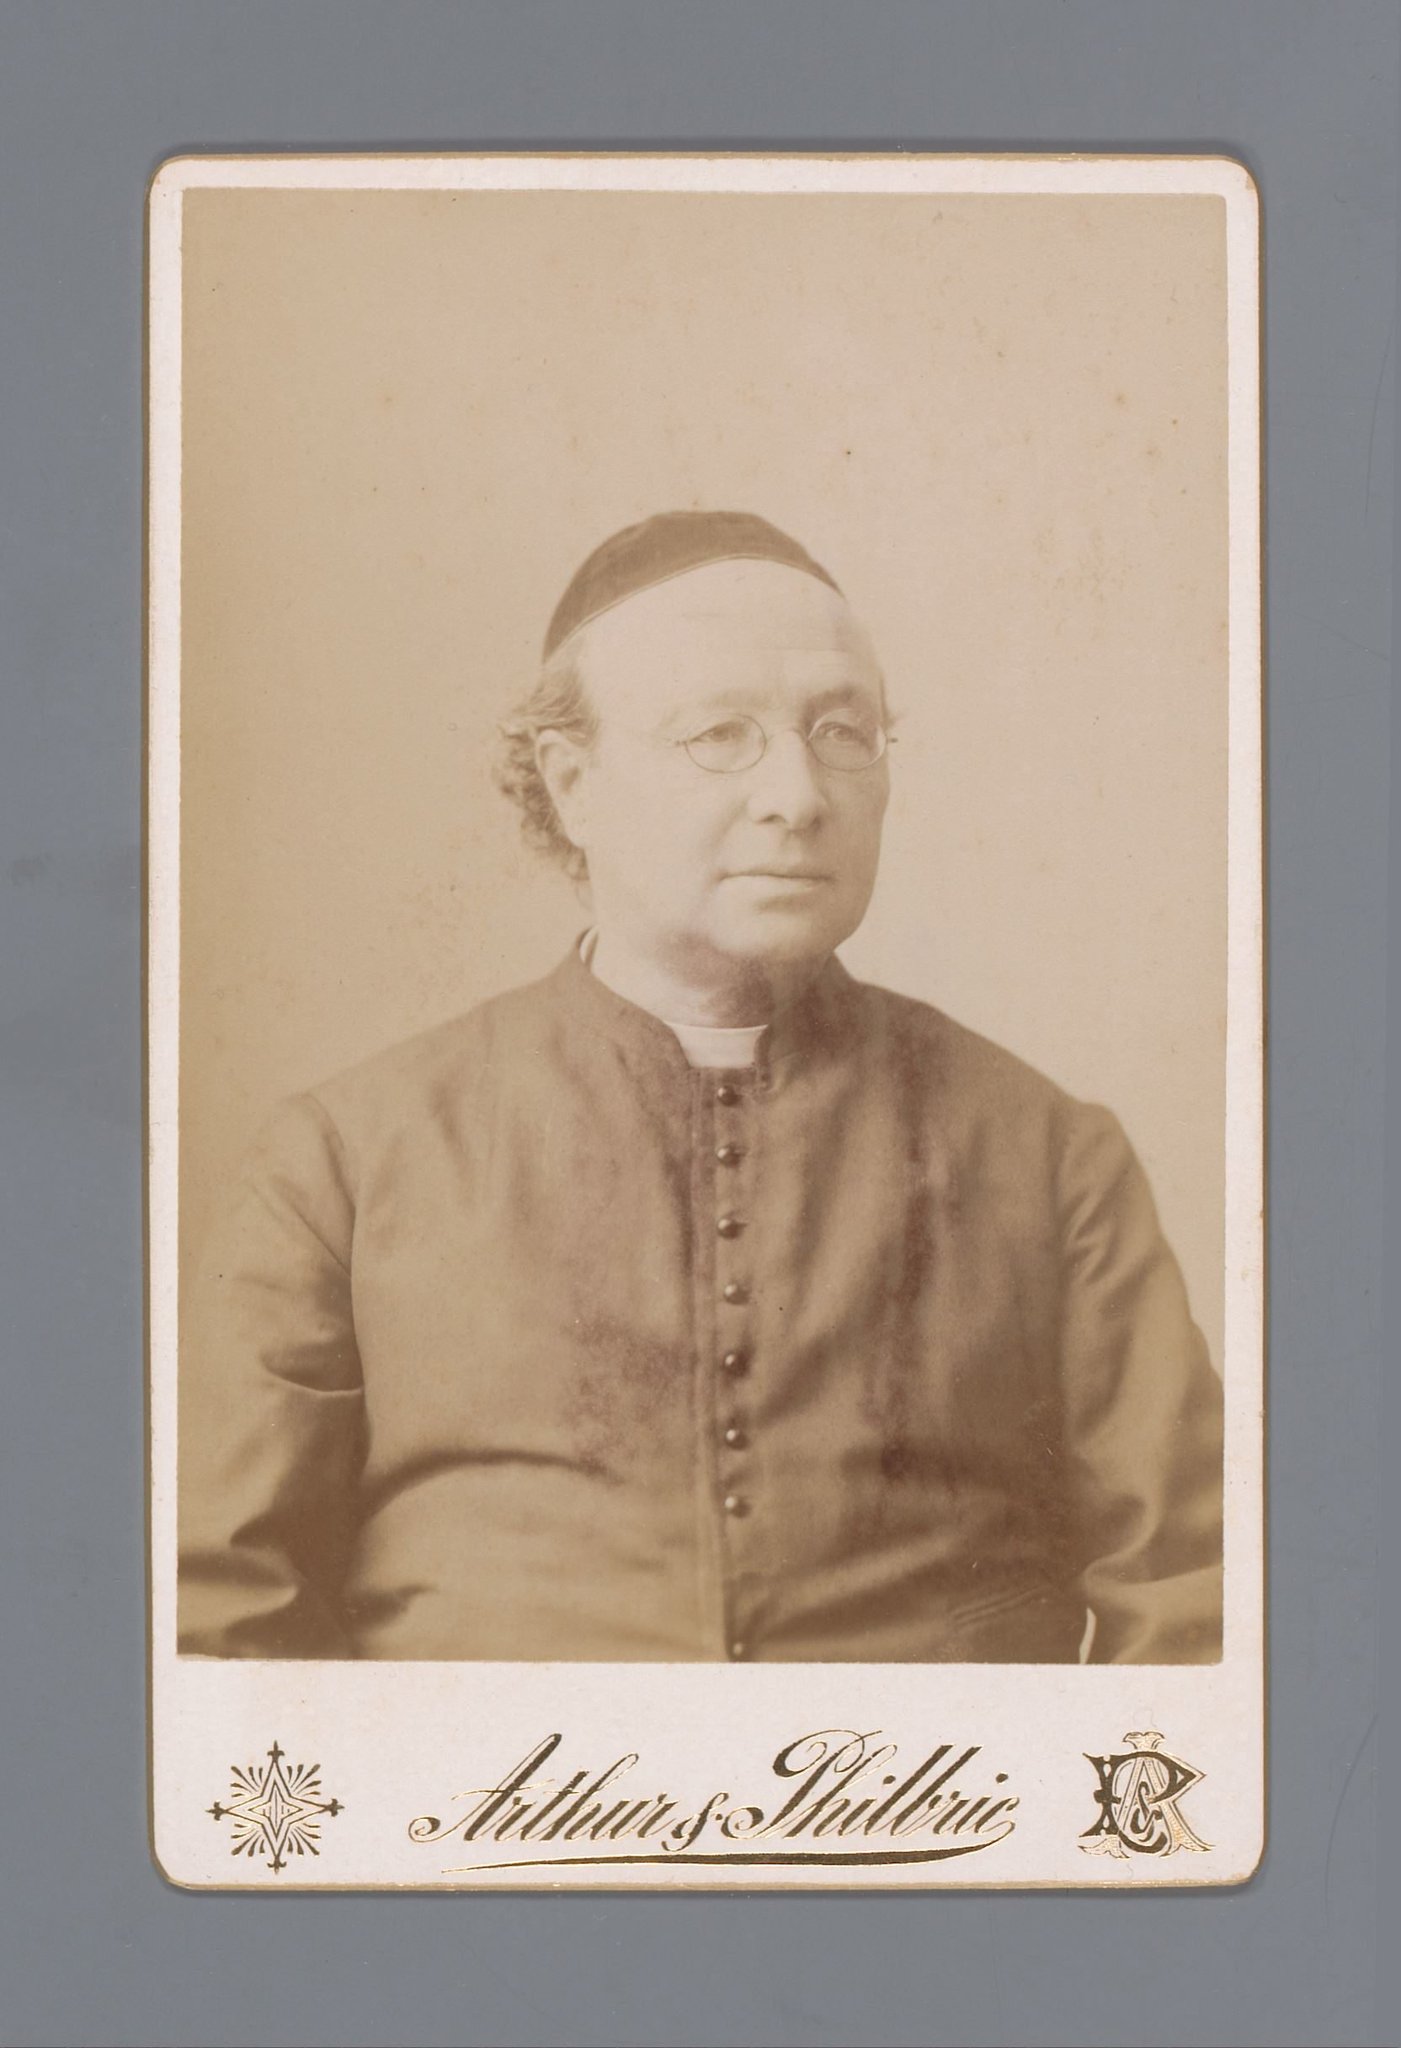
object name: cabinet photograph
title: Portret van een onbekende man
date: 1880-1900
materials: cardboard, photographic support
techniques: collodion silver print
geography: north and central america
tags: adult man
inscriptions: name: ‘Arthur & Philbric’, inscription: ‘Arthur & Philbric (...) Grand Rapids, Mich.’